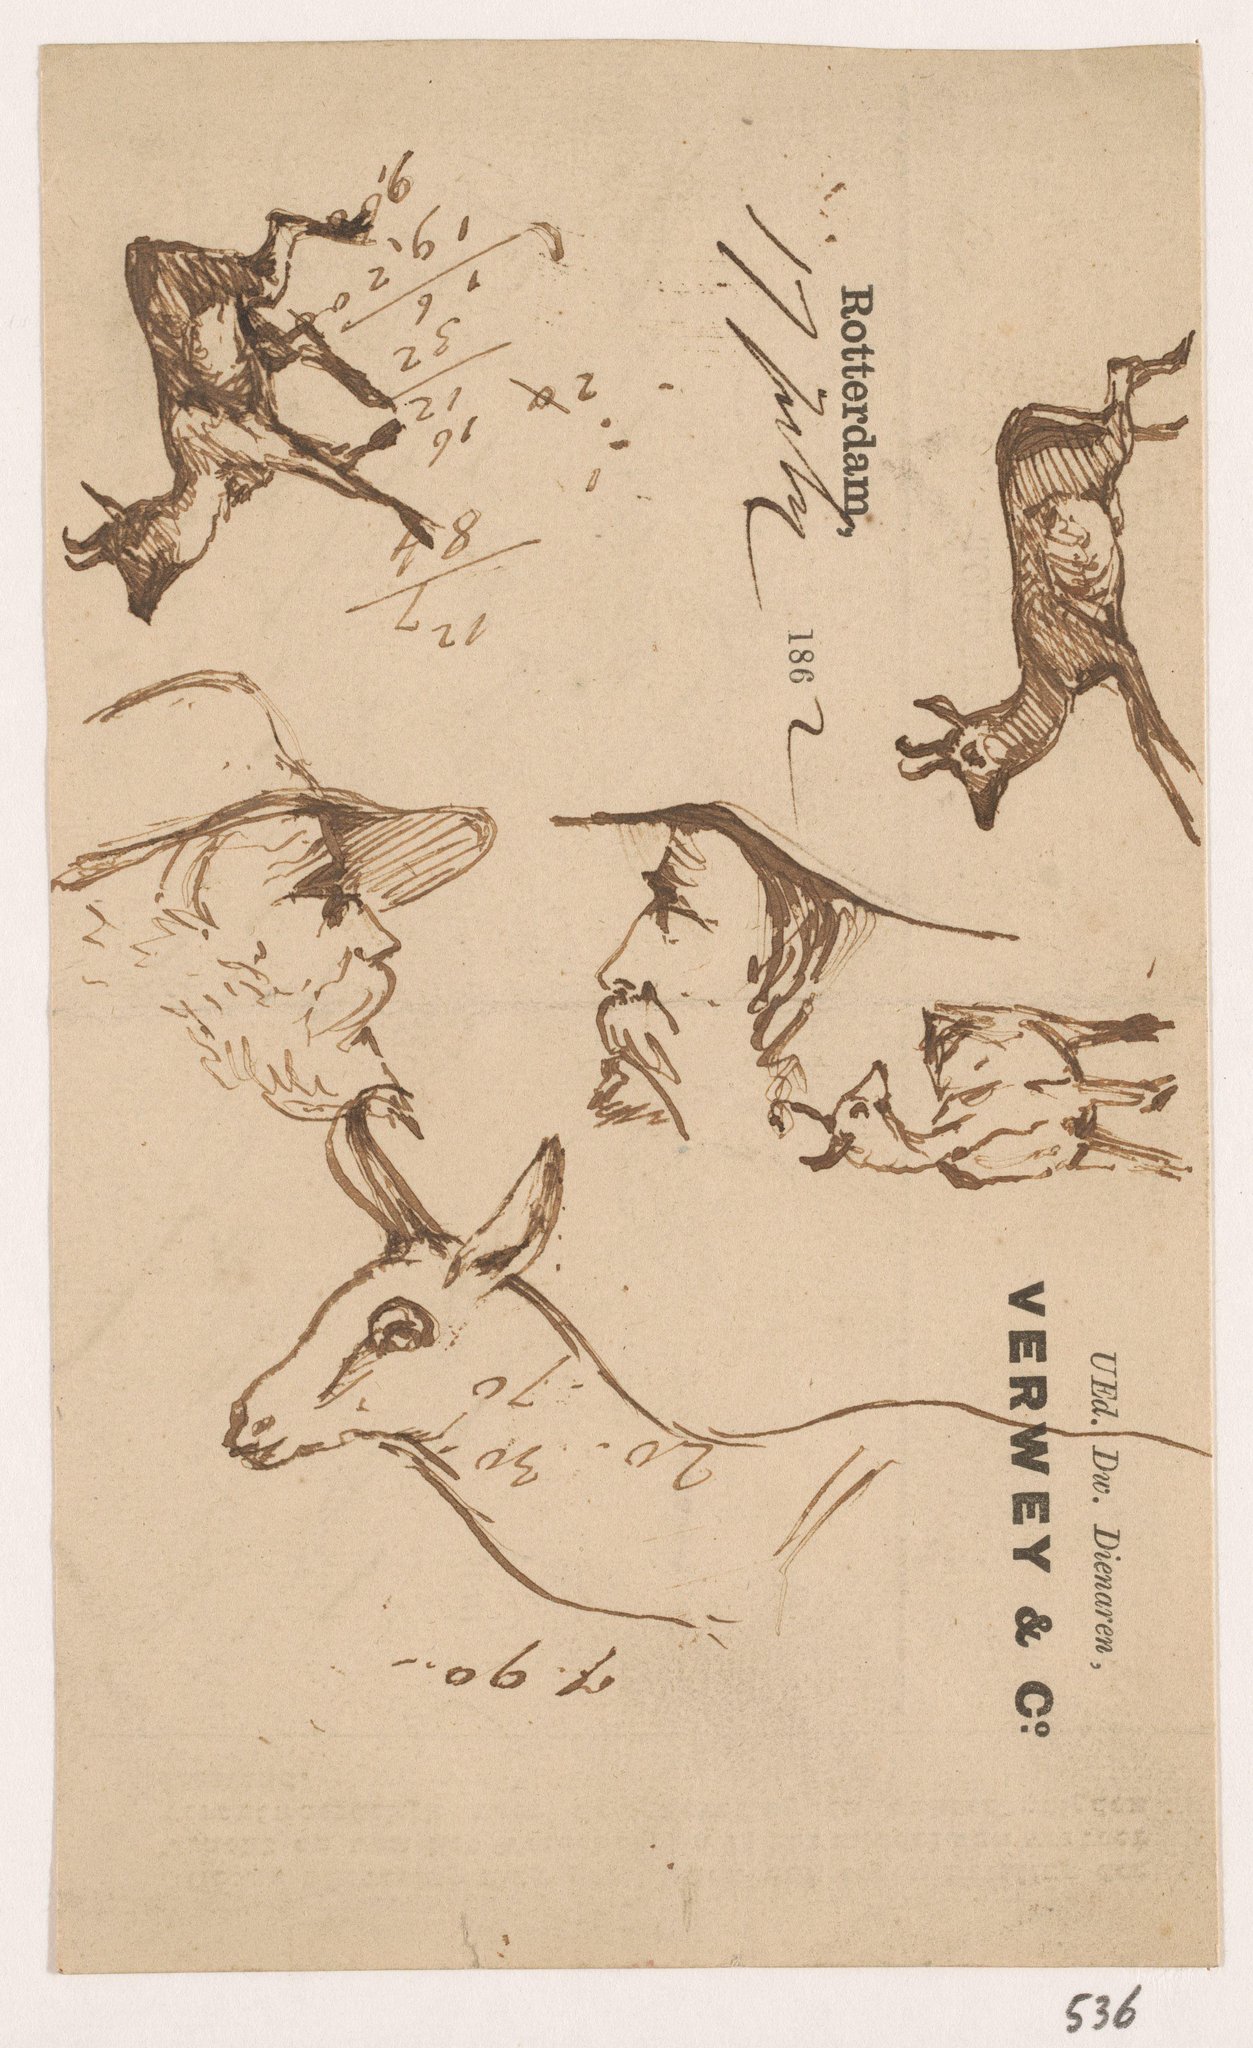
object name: drawing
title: Schetsblad met koppen en herten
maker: johannes tavenraat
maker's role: draughtsman, painter, print maker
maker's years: 1809-1881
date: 1862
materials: ink, paper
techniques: pen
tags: head (human), hoofed animals: deer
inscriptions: collector's mark: Lugt 2228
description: Schetsblad met koppen en herten. Getekend op de voorzijde van een deel van een drukwerk gericht aan Tavenraat en gedateerd 17 juli 1862.